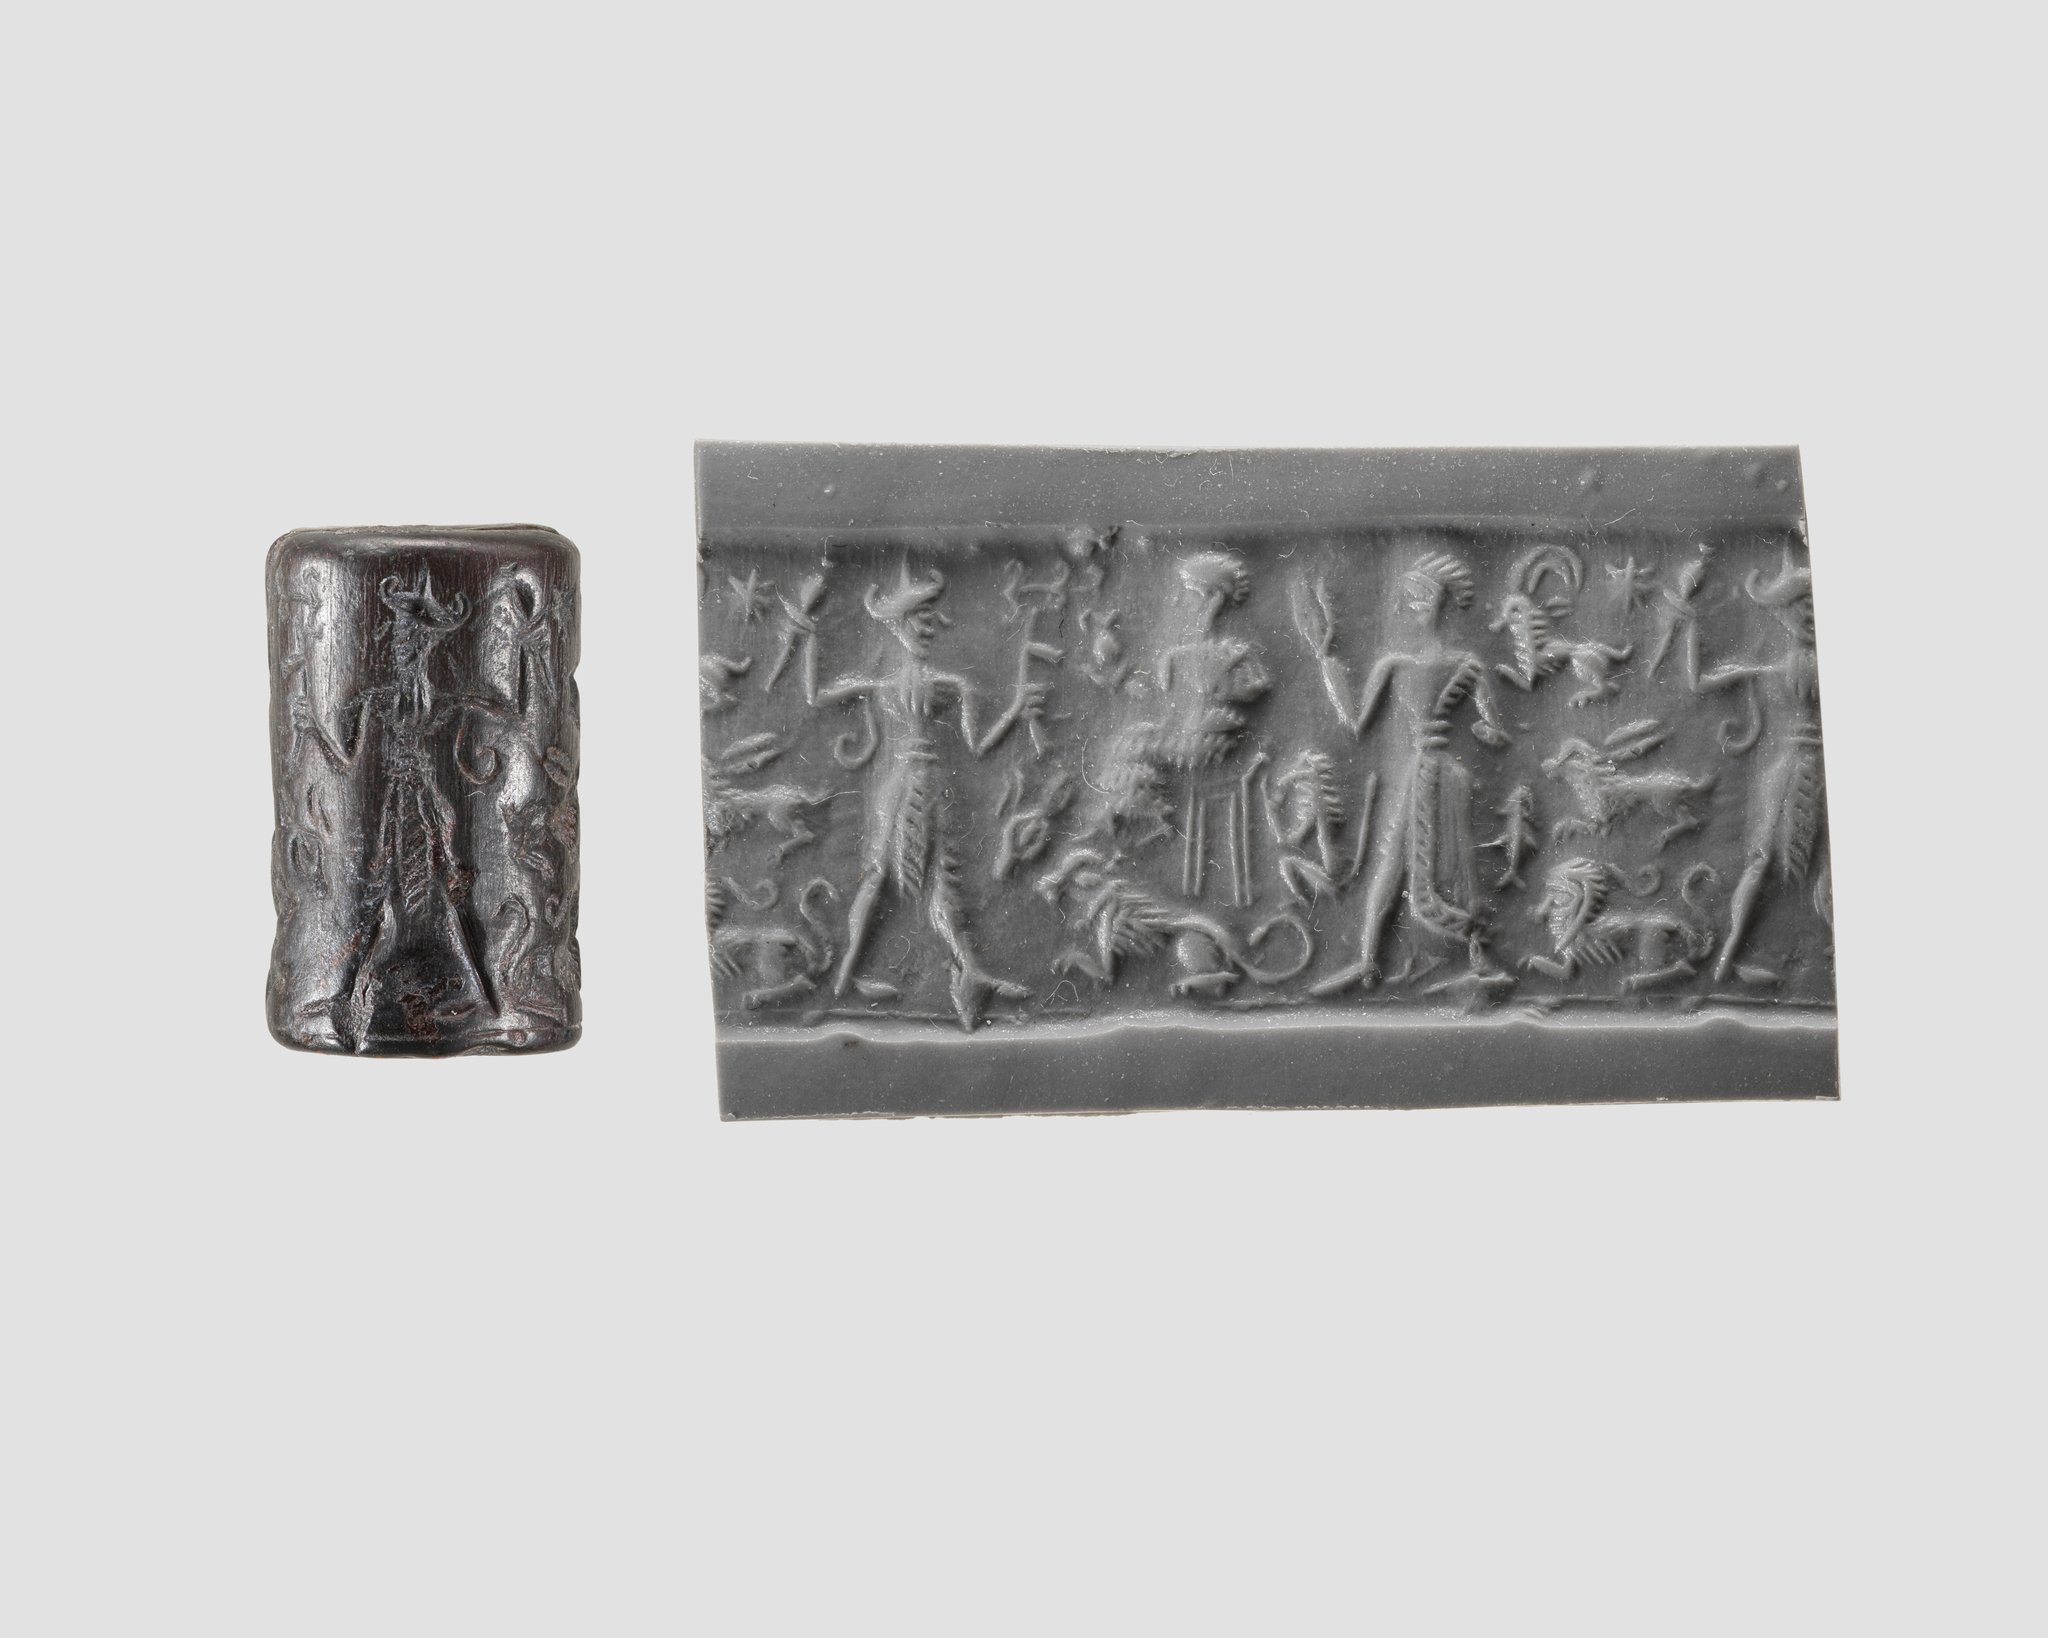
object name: cylinder seal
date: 1820-1730 BCE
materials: mineral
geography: syria